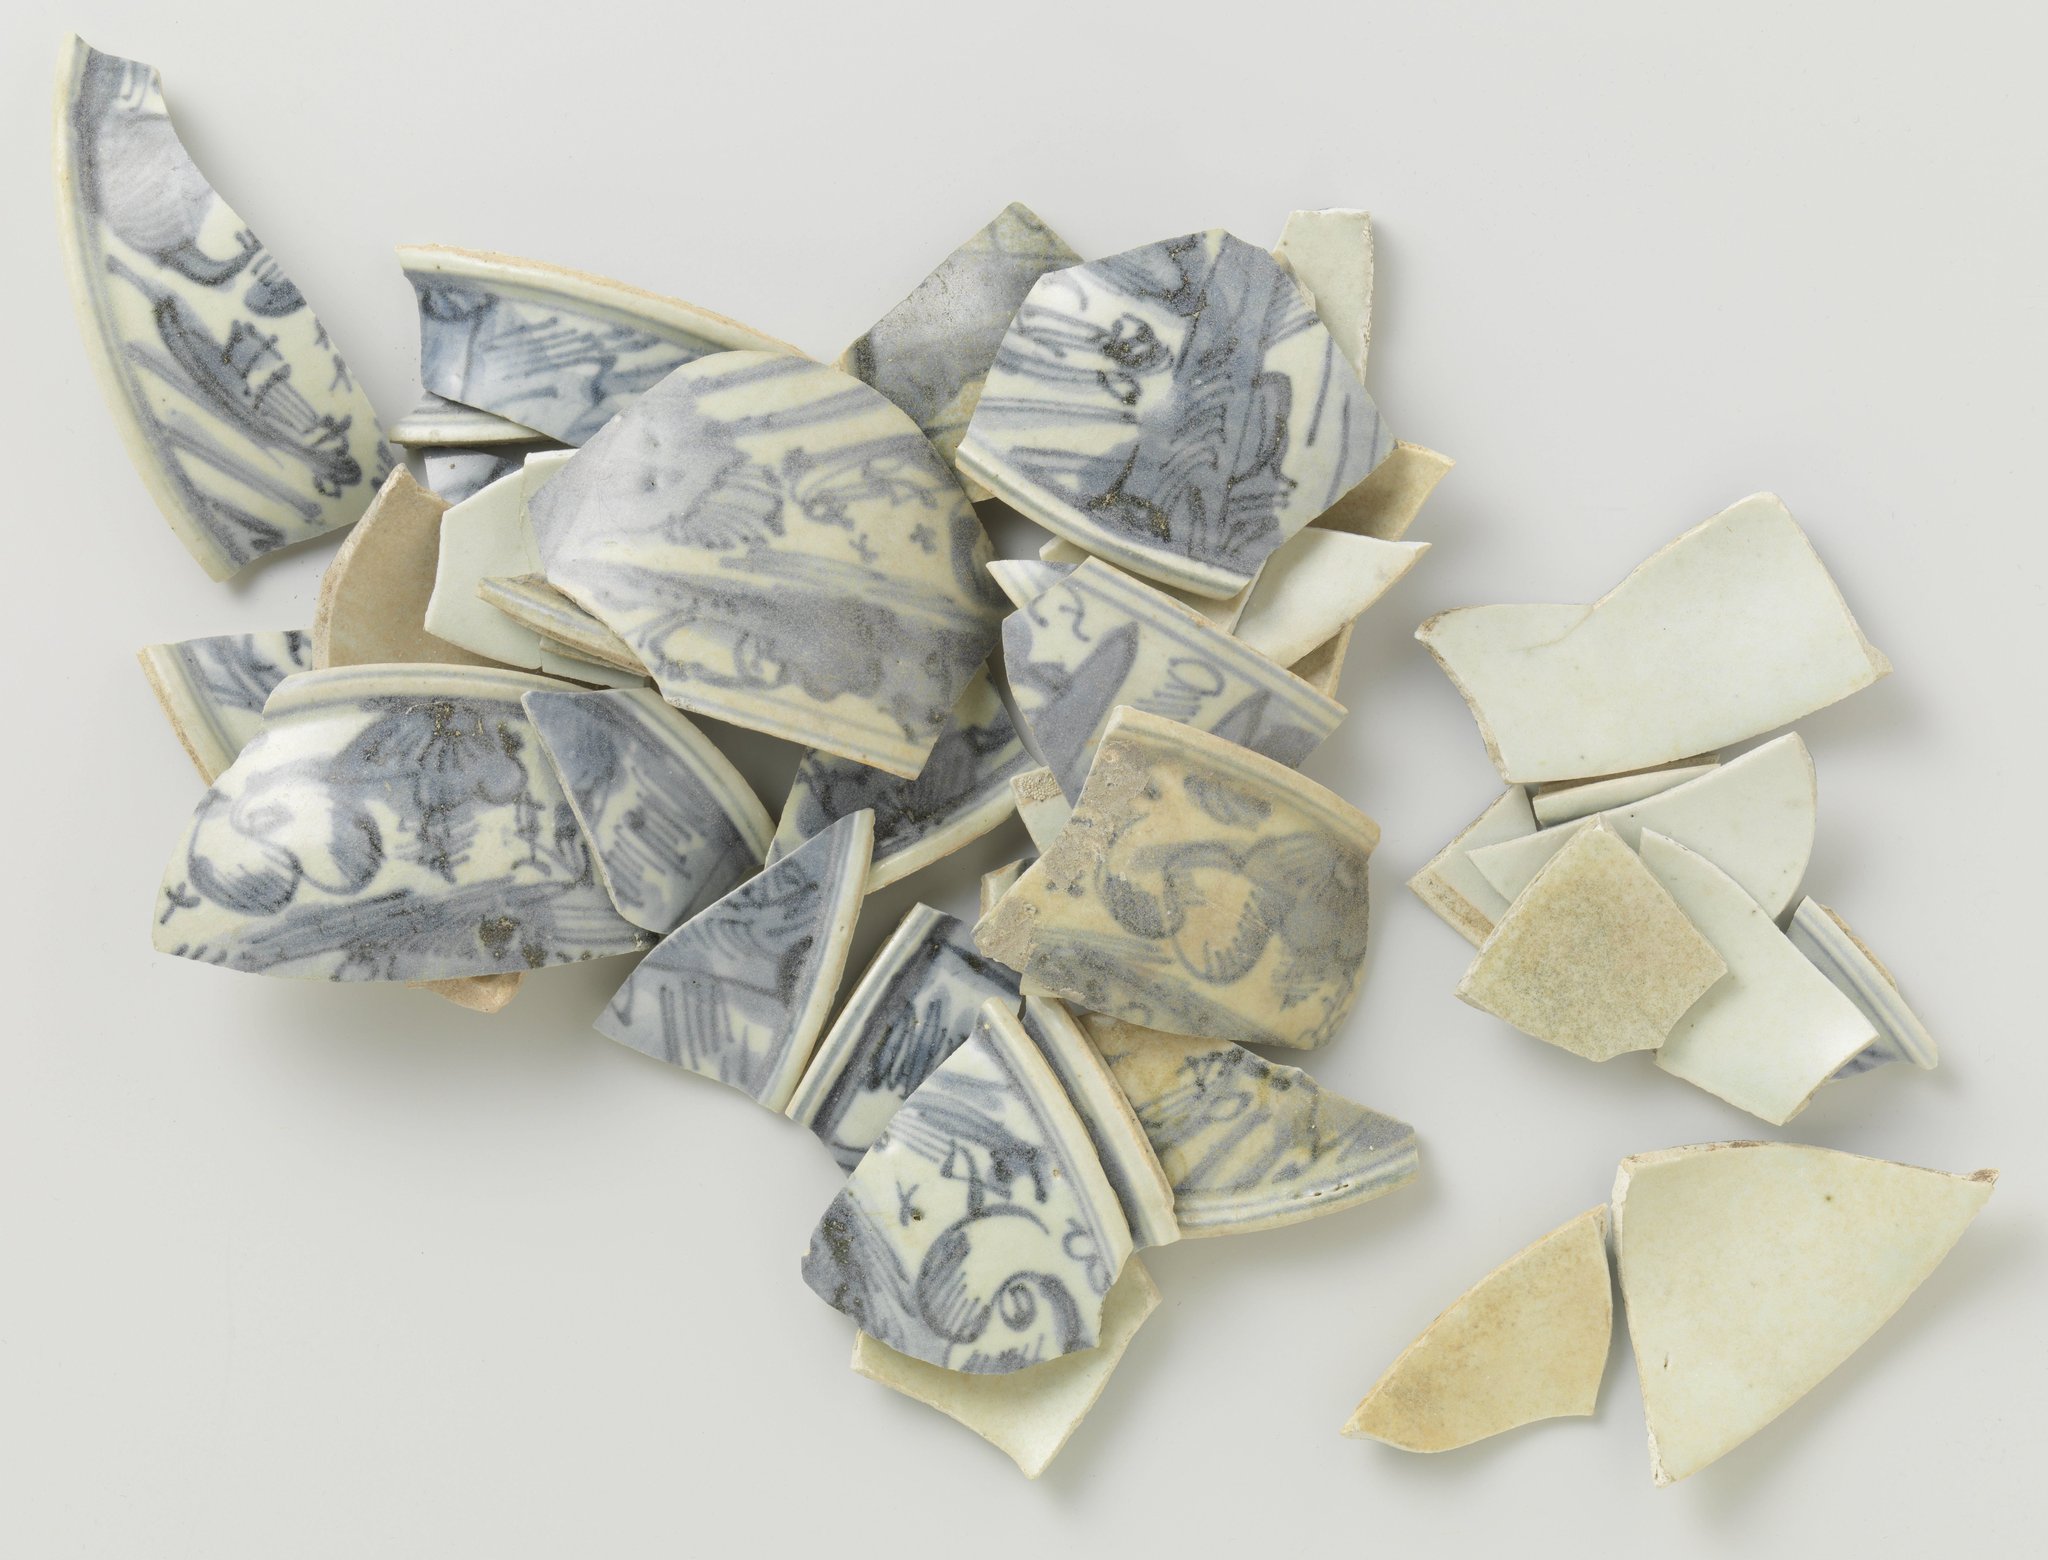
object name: sherd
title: Scherven van porselein van kommen uit V.O.C.-schip de 'Witte Leeuw'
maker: Anonymous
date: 1613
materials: porcelain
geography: jingdezhen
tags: verenigde oostindische compagnie, sint-helena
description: Scherven van porselein van kommen uit V.O.C.-schip de 'Witte Leeuw'.